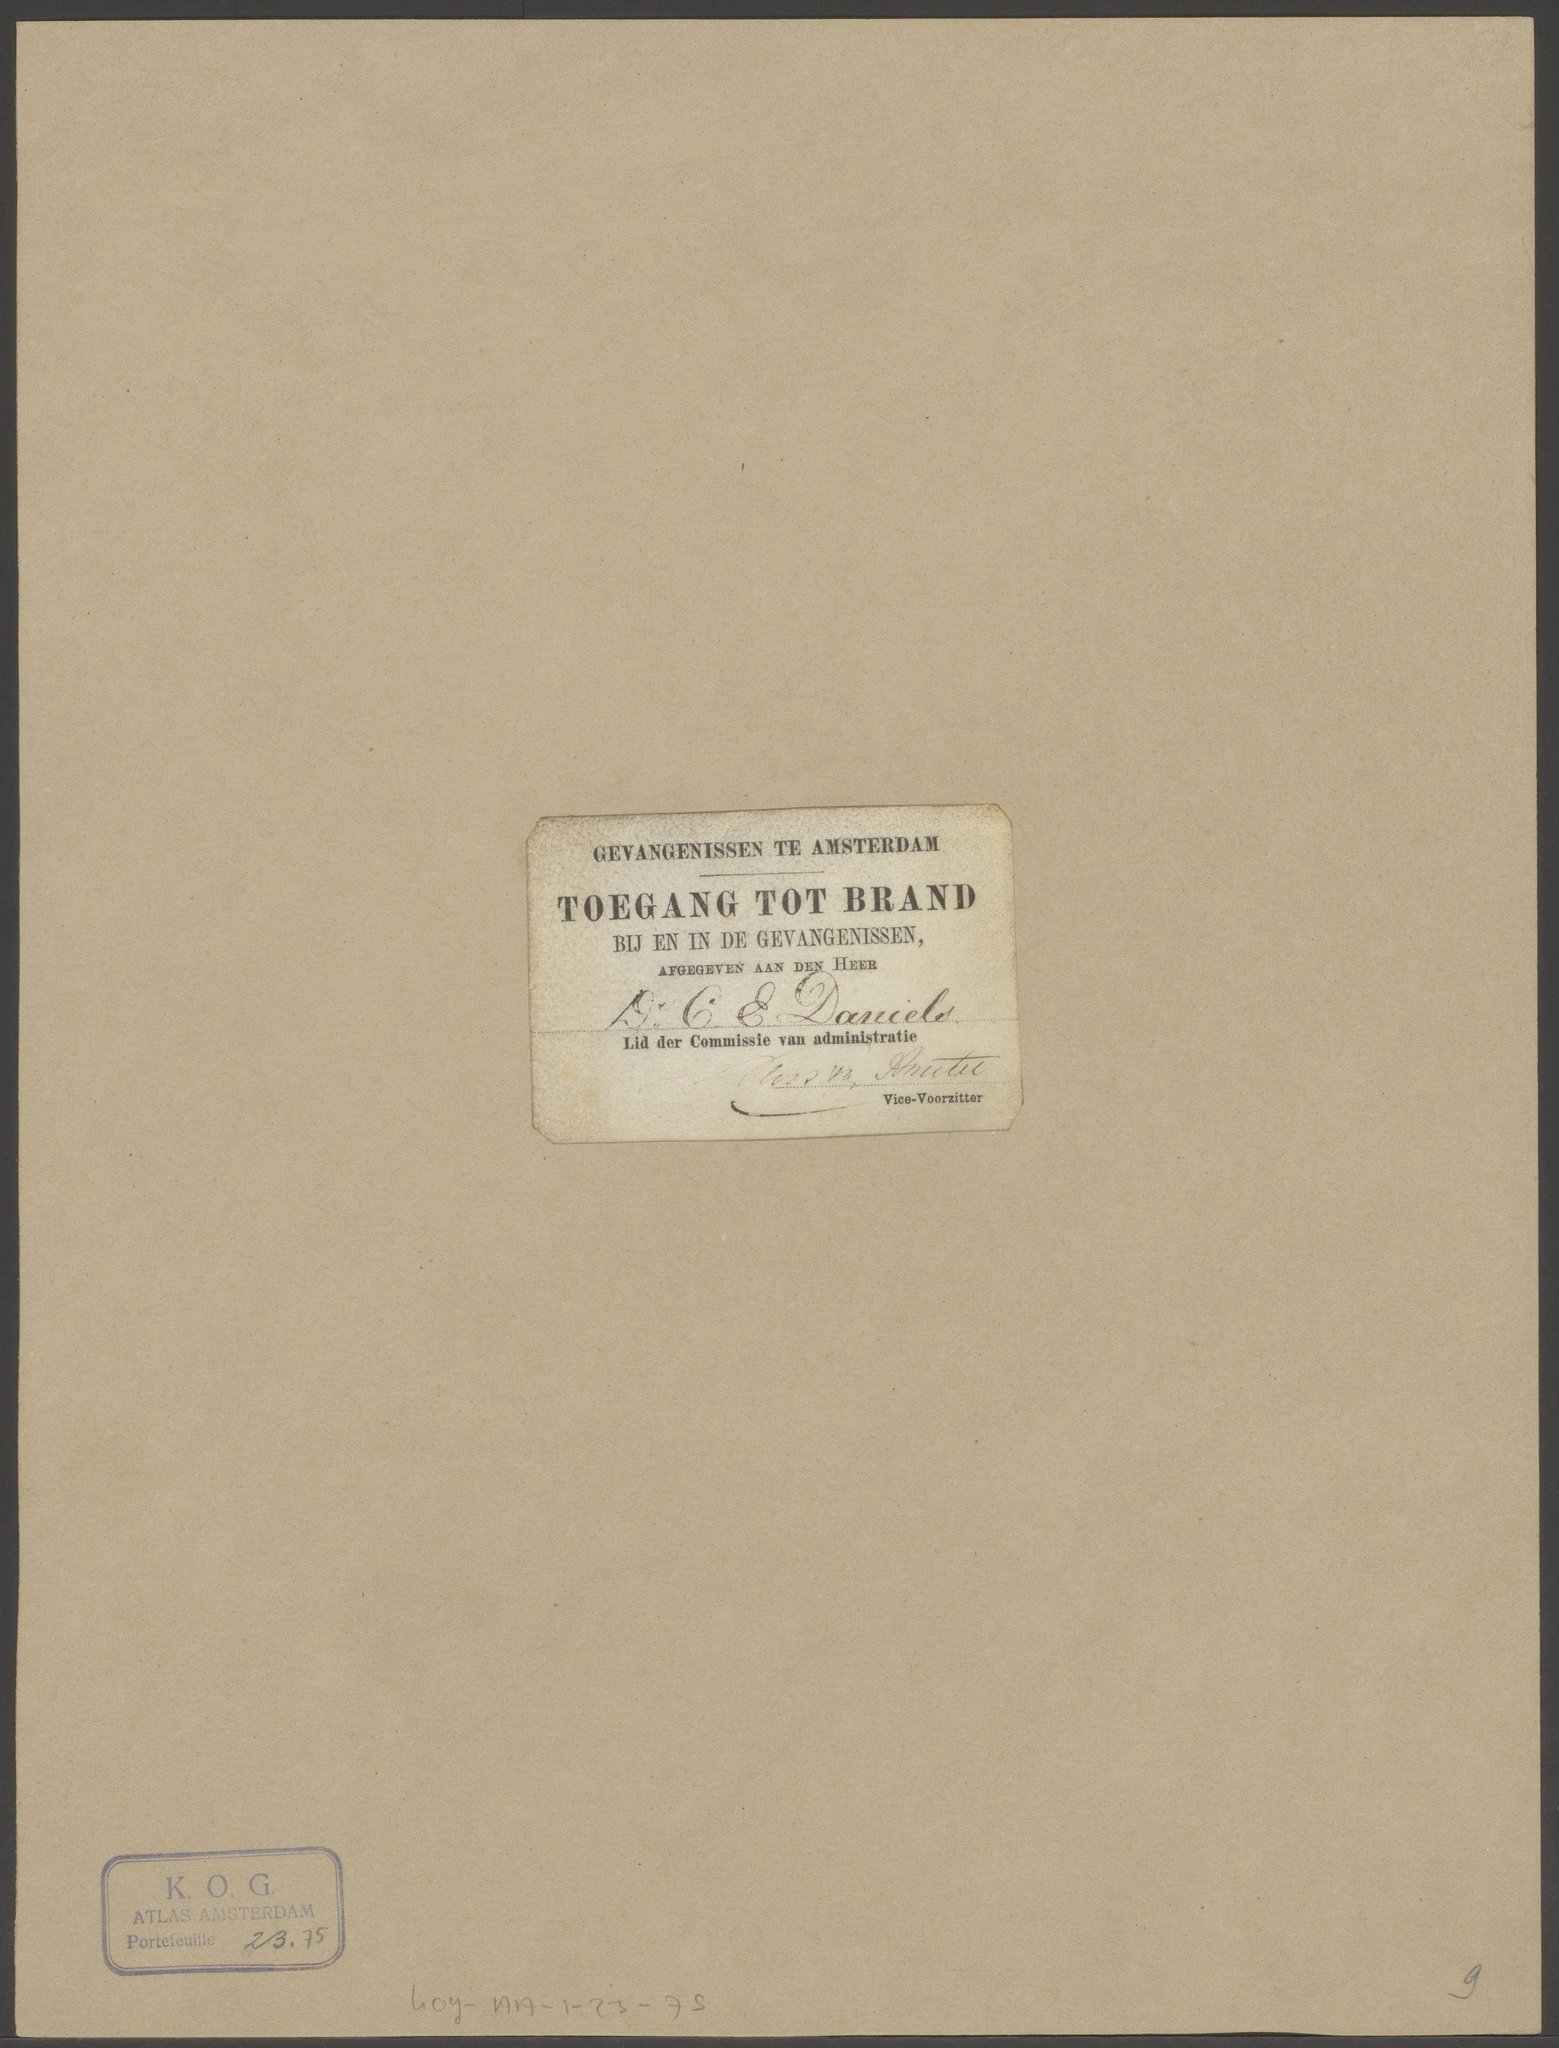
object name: admission ticket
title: Toegangsbewijs bij brand in de gevangenissen van Amsterdam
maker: Anonymous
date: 1801-1900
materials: parchment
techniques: letterpress printing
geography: netherlands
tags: prison, jail, on fire, ablaze, amsterdam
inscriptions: collector's mark: Lugt 1641b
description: Toegangsbewijs uitgegeven aan D.C.E. Daniels. Onderwerpsrubriek binnen de Atlas Amsterdam: Rechtswezen.